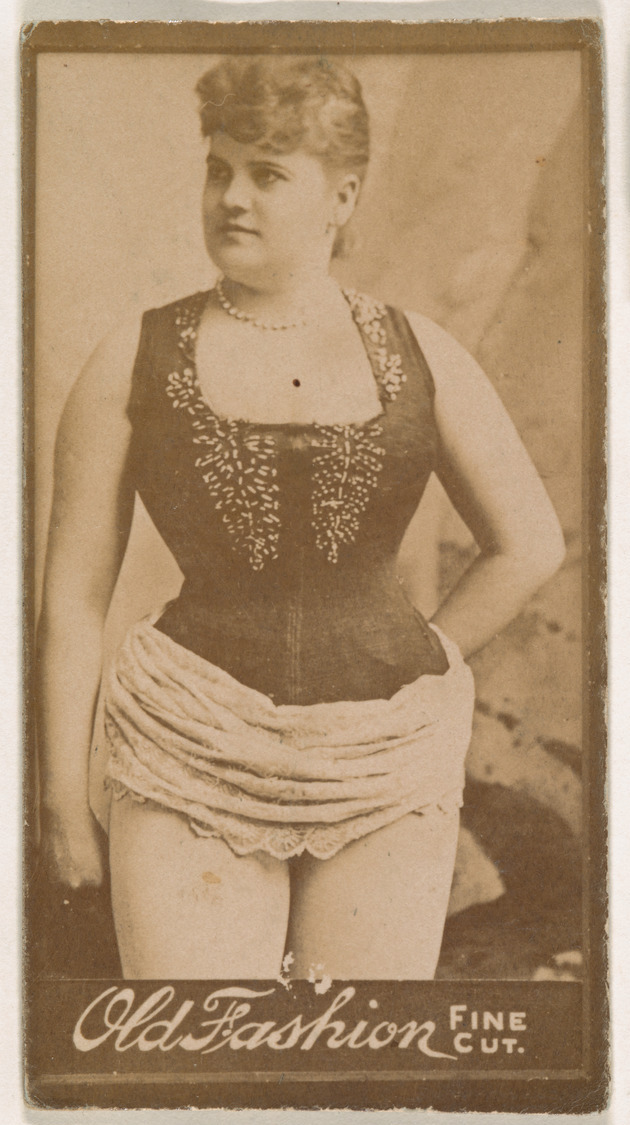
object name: photograph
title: Actress standing with hand on hip, from the Actresses series (N664) promoting Old Fashion Fine Cut Tobacco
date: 1888-1890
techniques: albumen silver print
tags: portraits,women,actresses